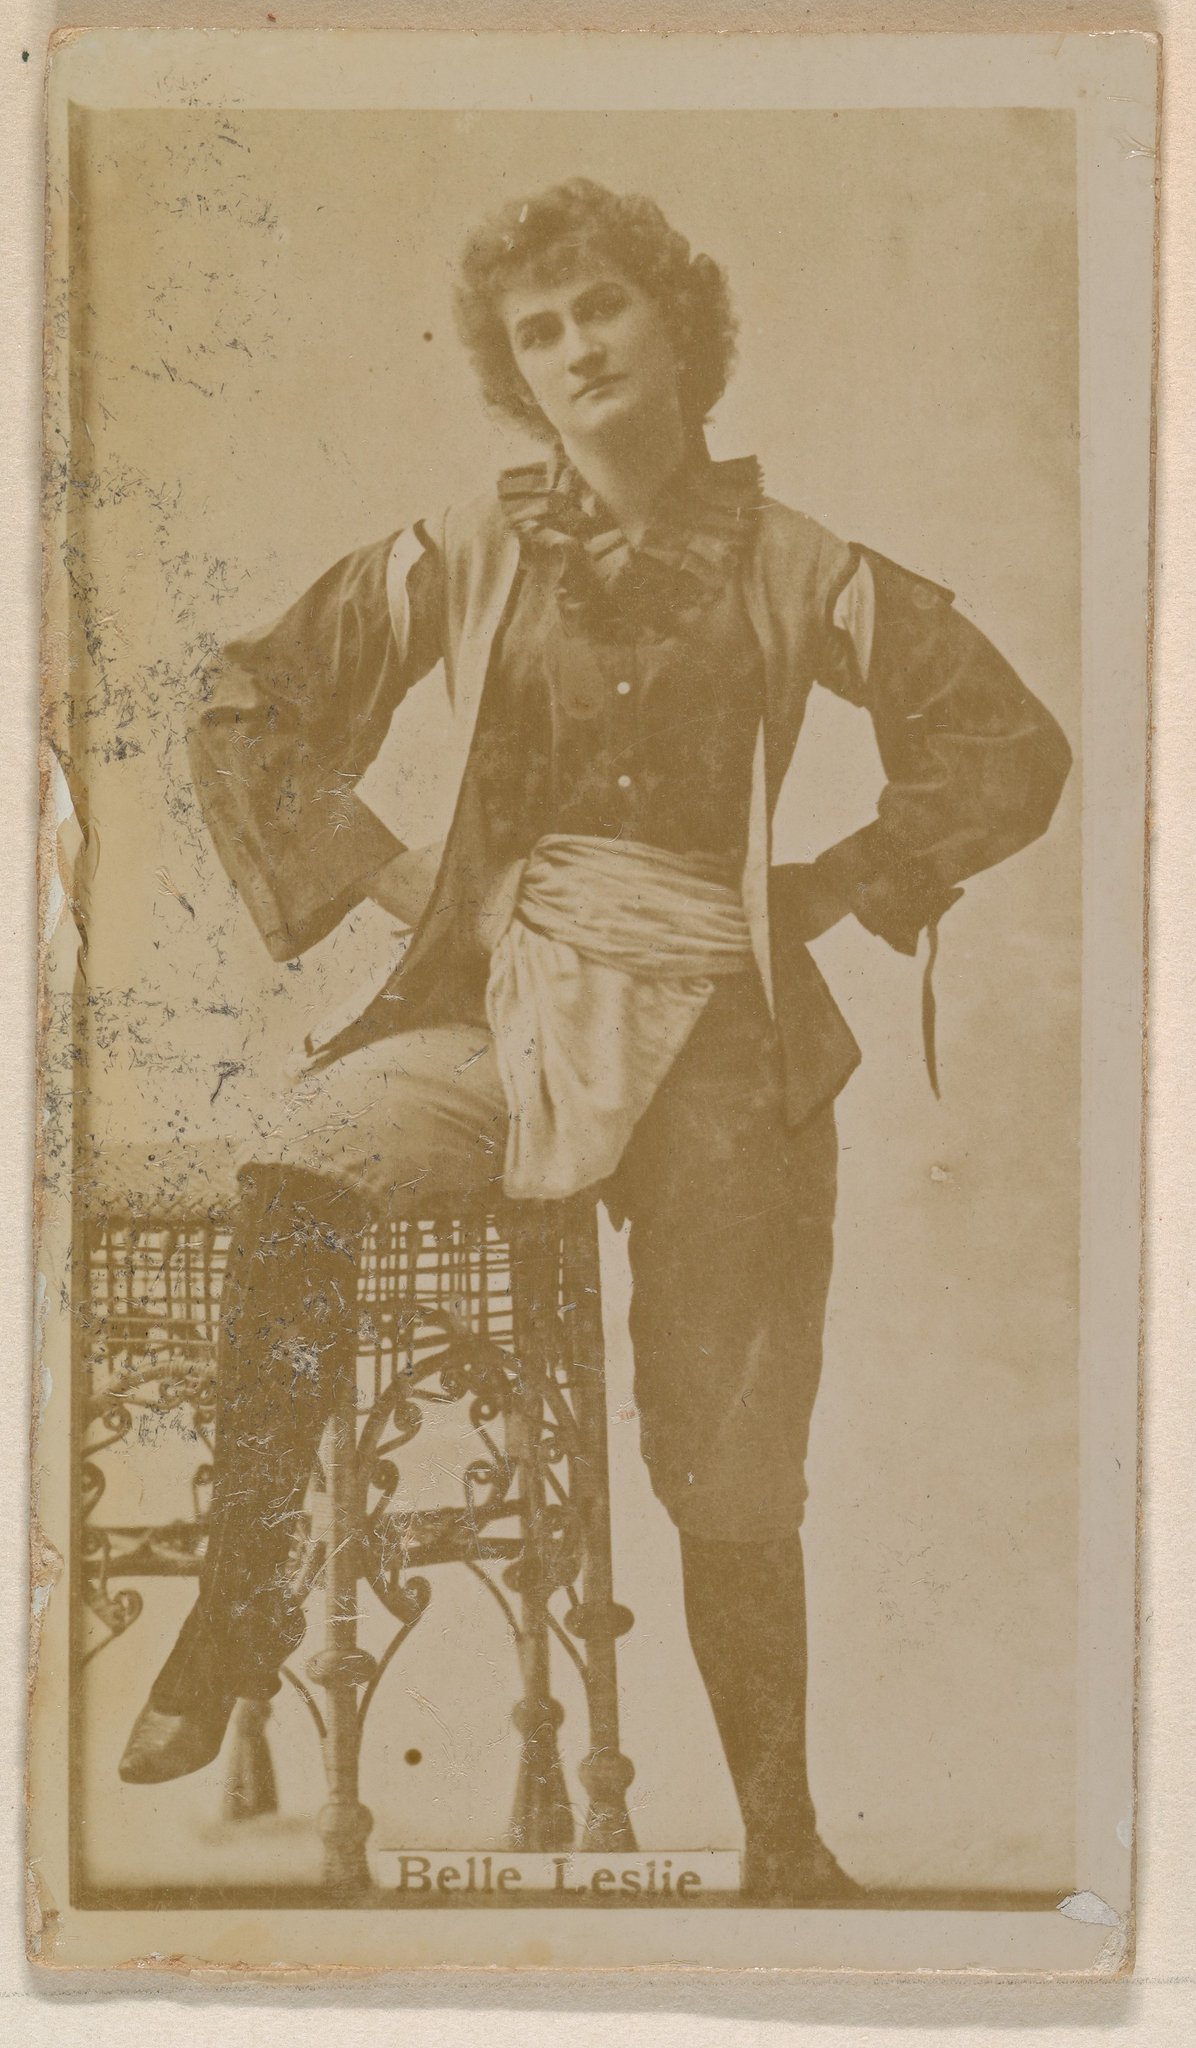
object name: photograph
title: Belle Leslie, from the Actresses series (N245) issued by Kinney Brothers to promote Sweet Caporal Cigarettes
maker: kinney brothers tobacco company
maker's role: publisher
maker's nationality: american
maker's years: 1869-2011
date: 1890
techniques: albumen silver print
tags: portraits,women,actresses